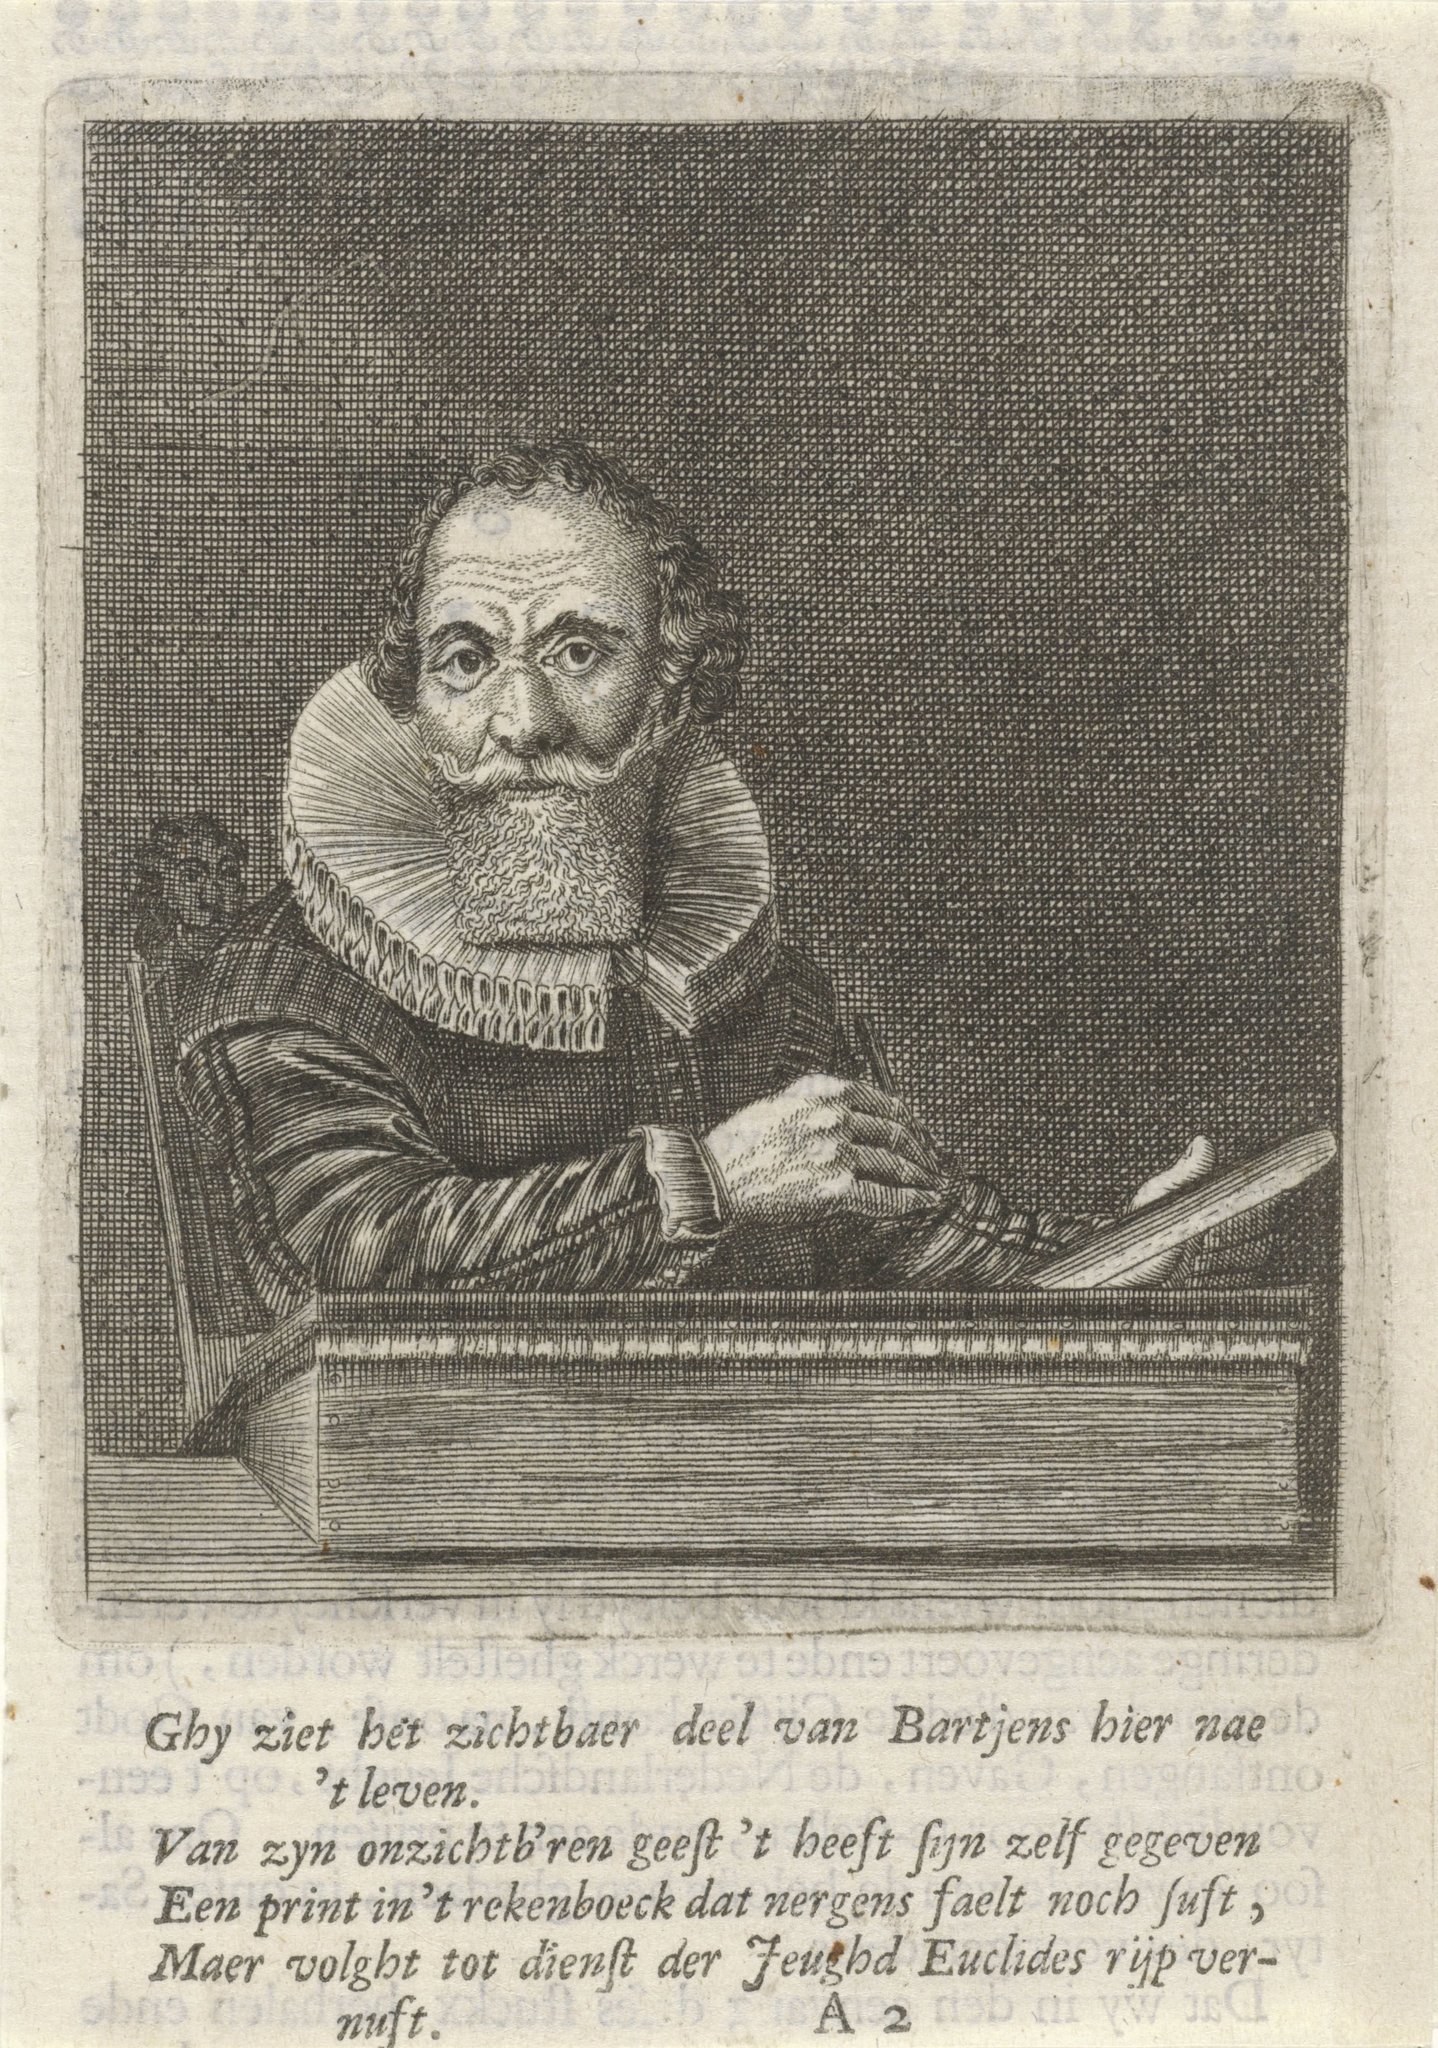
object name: print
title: Portret van de rekenmeester Willem Bartjens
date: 1636-1715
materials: paper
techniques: engraving, etching, letterpress printing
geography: amsterdam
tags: amsterdam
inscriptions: collector's mark: Lugt 2228